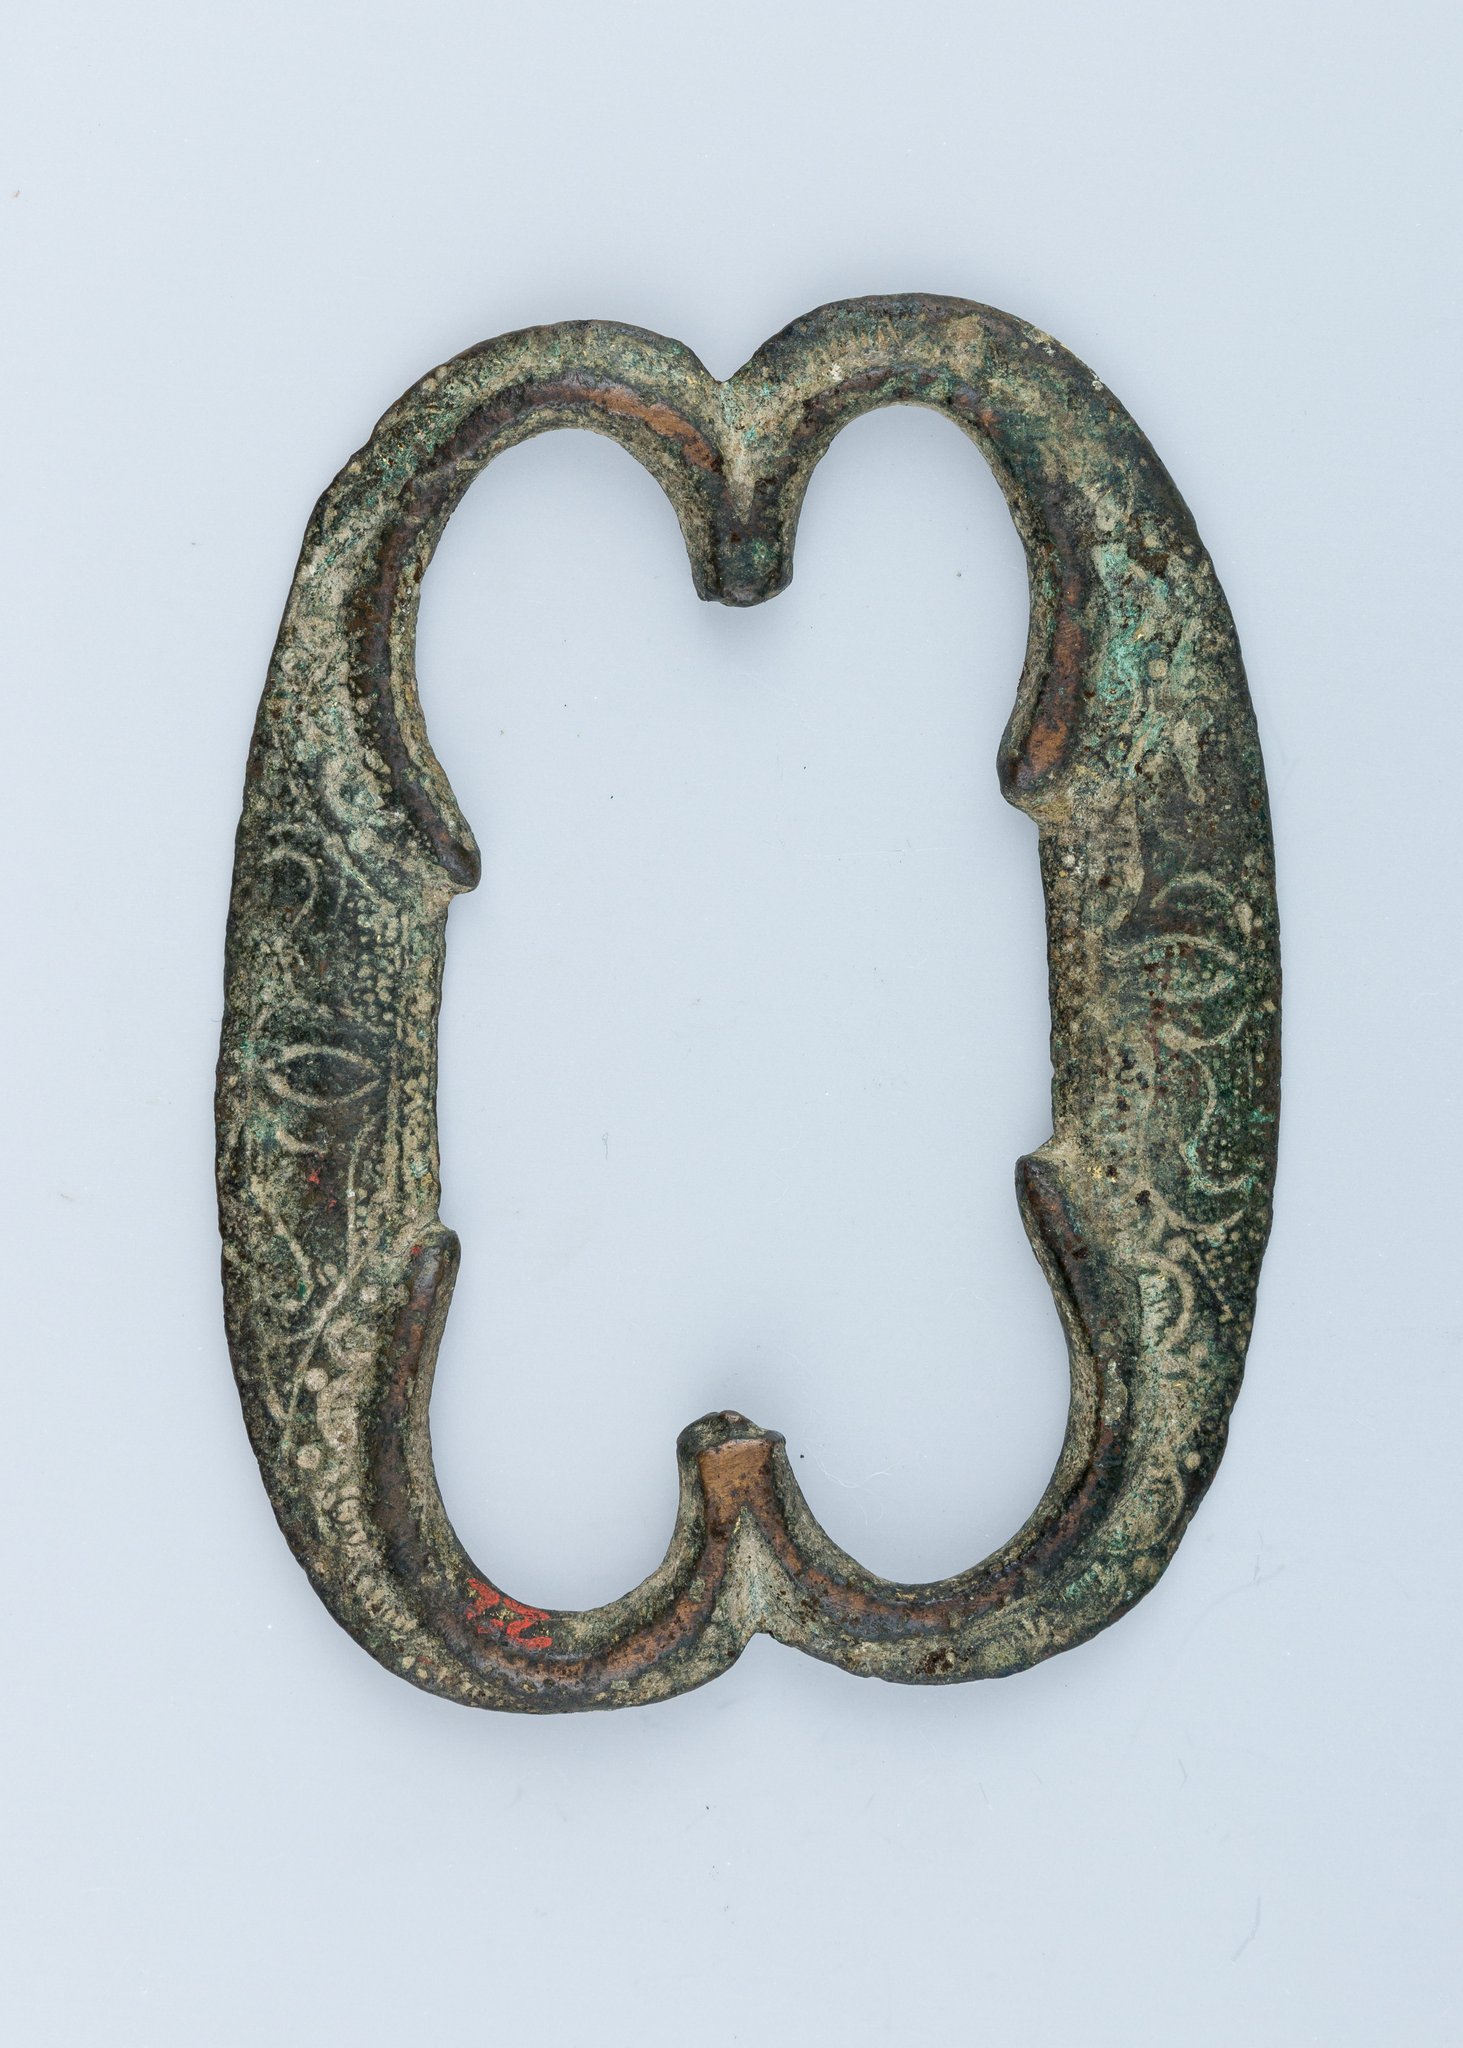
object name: buckle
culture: spanish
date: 1401-1500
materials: bronze, patina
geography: spain